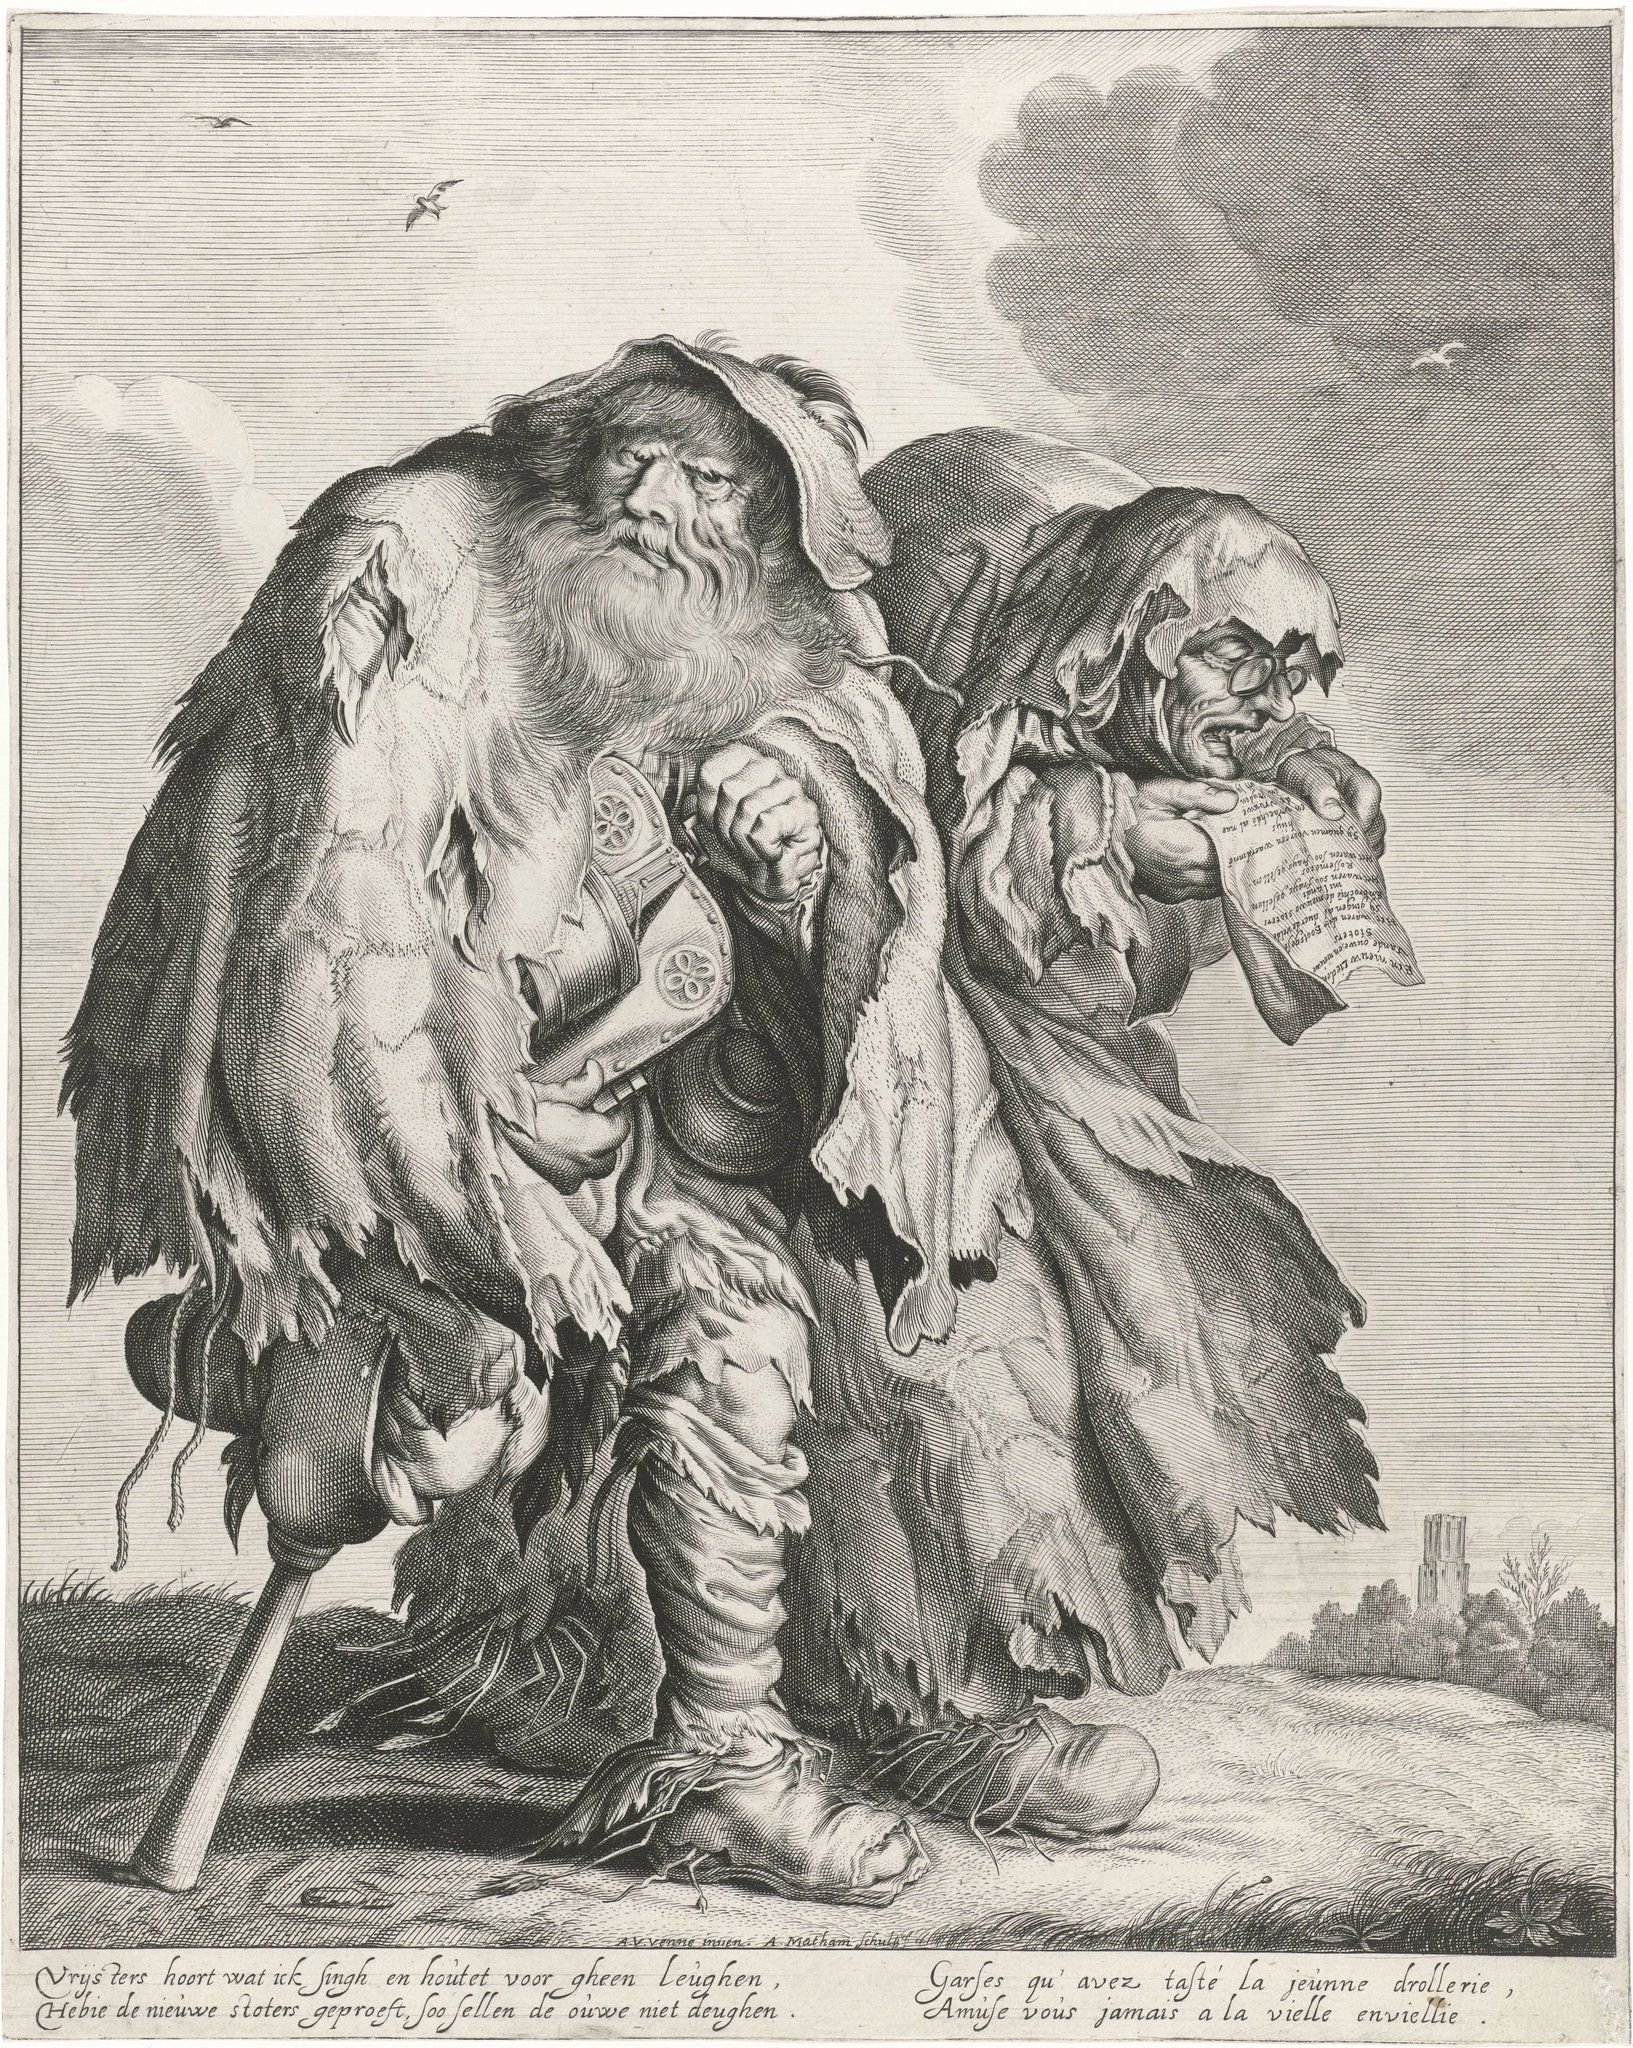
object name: print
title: Two Beggars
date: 1620-1660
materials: paper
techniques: engraving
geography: northern netherlands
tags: wooden leg, hurdy-gurdy player, vocal popular music, beggar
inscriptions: collector's mark: Lugt 2228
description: These are certainly not virtuous poor people. The man is only pretending that he needs a wooden leg. The woman is screeching some bawdy song about young lovers being more desirable than old ones.